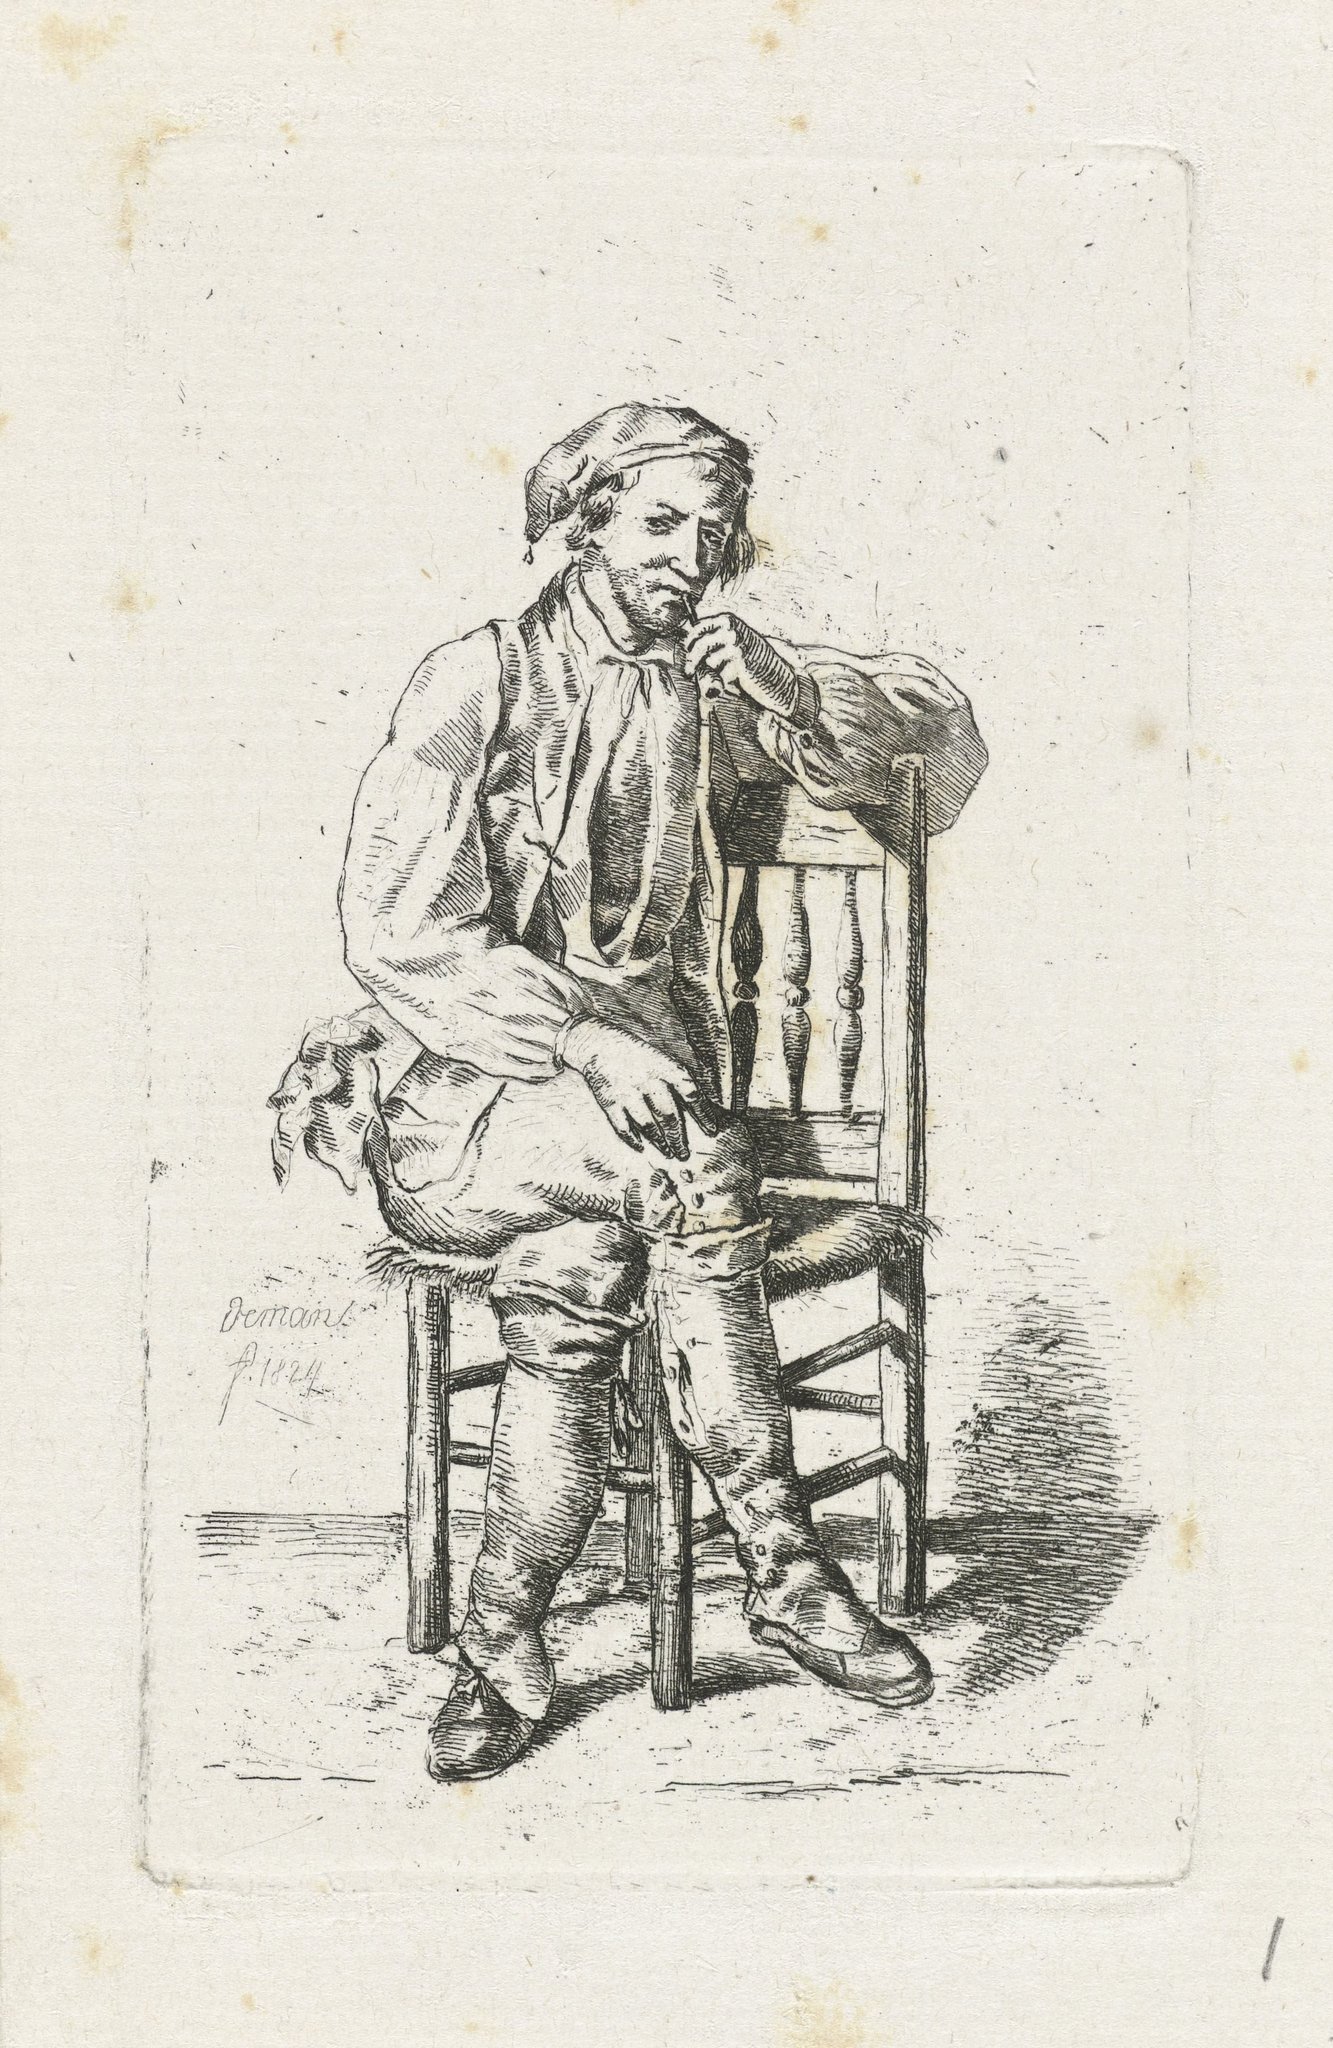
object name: print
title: Zittende man op een stoel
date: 1824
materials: paper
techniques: etching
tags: sitting figure (+ three-quarter view)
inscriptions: collector's mark: Lugt 2228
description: Man met zijn benen over elkaar zittend op een stoel.